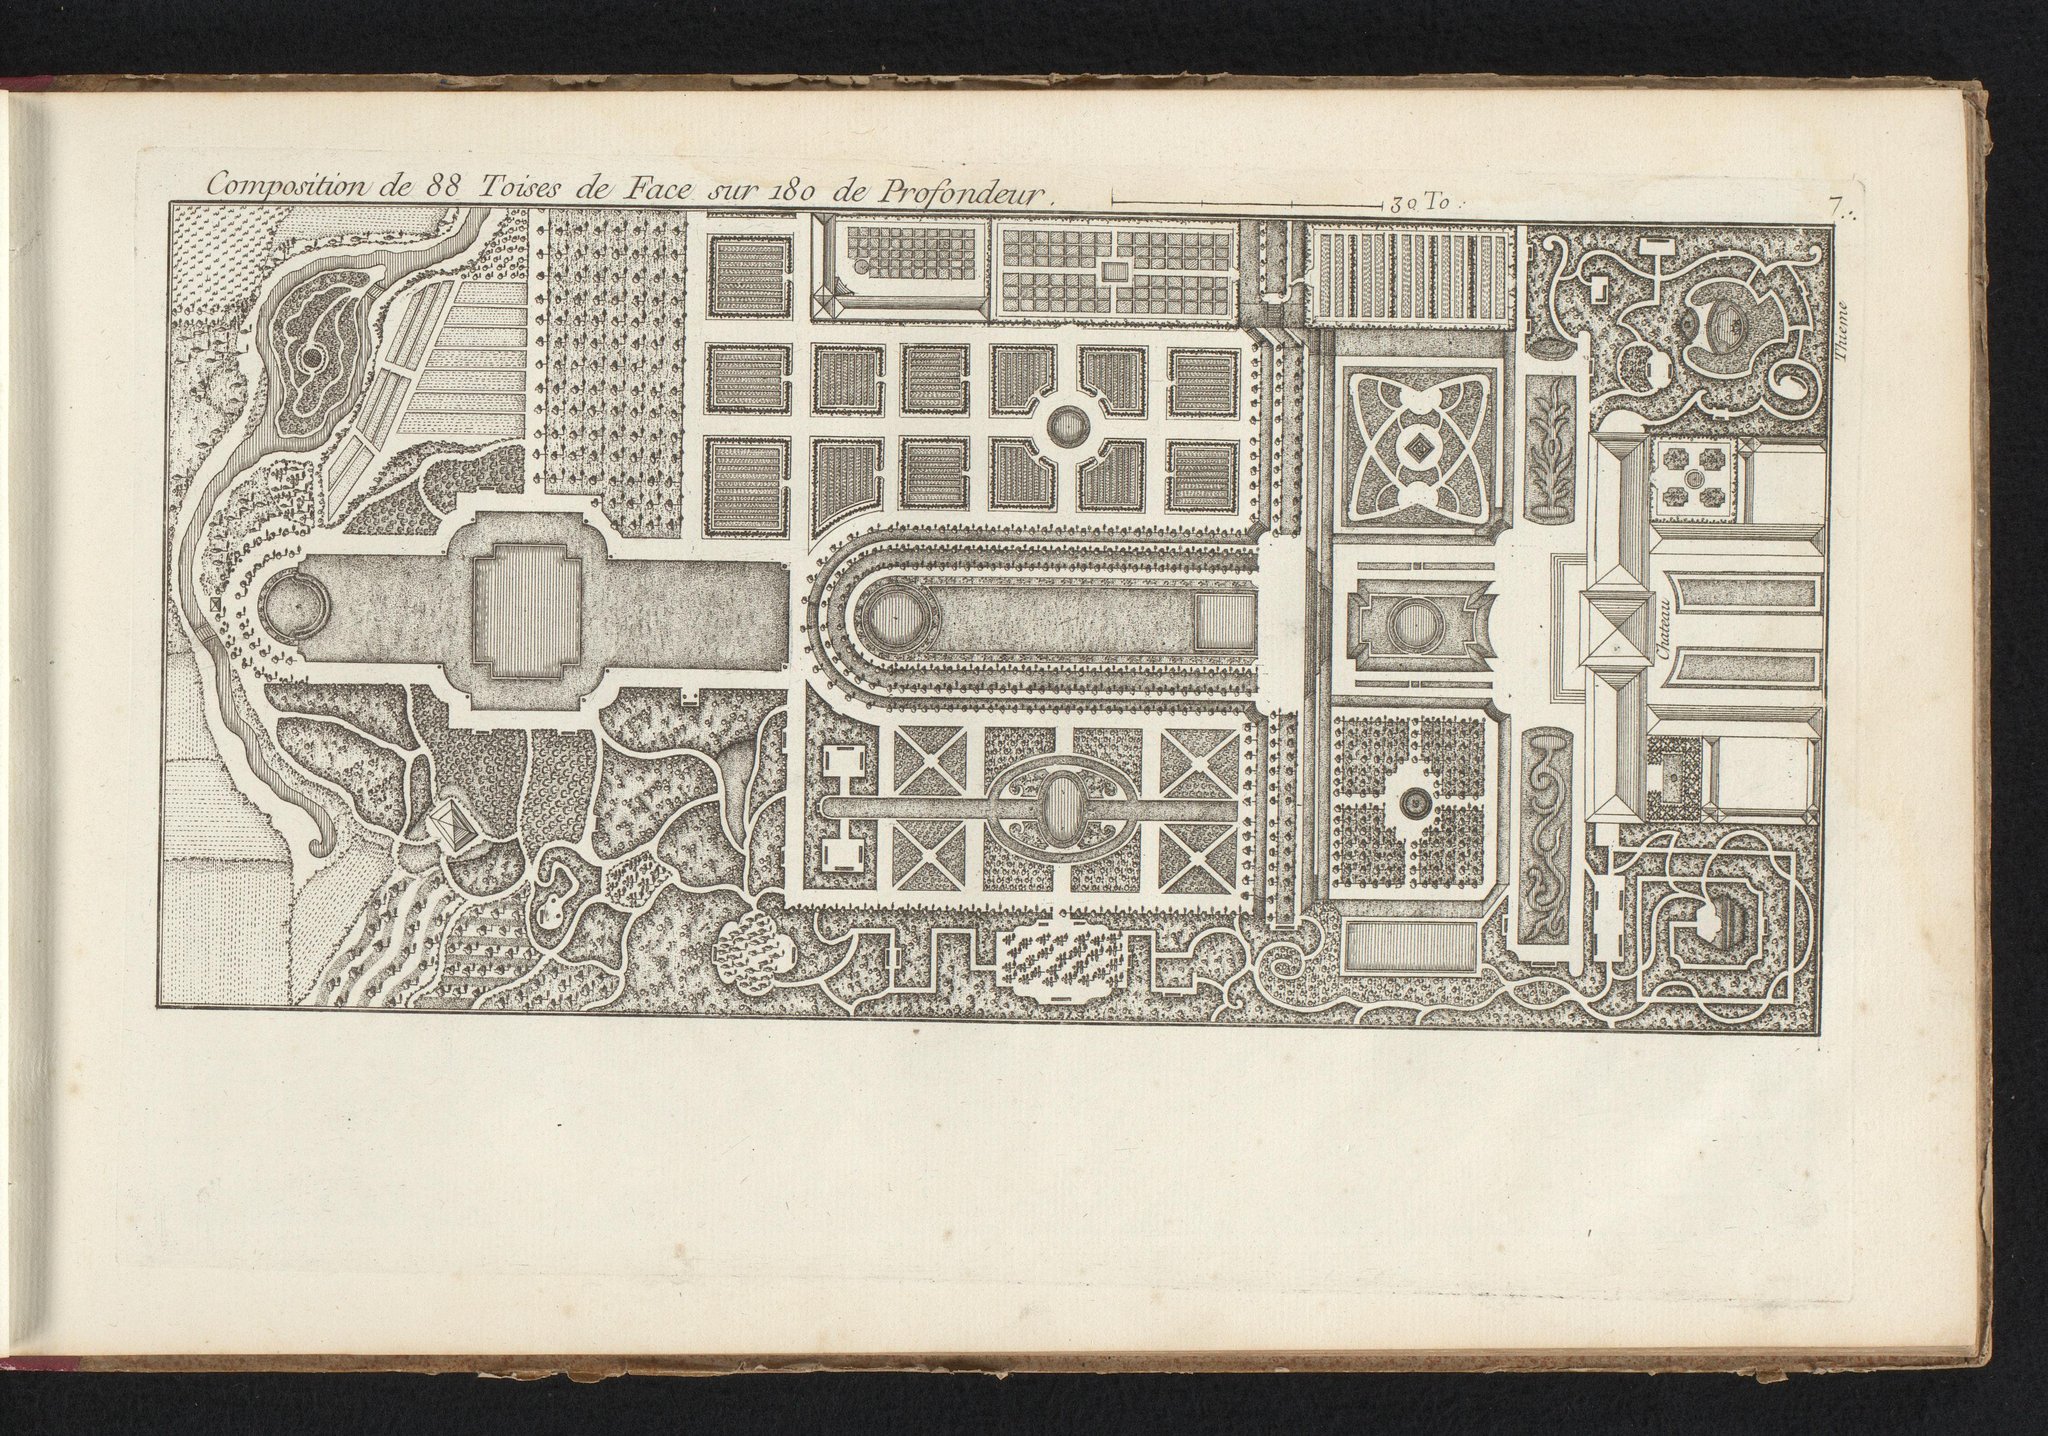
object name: album leaf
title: Ontwerp voor de tuin bij een kasteel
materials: paper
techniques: engraving, etching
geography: paris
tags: plan, map of garden, lay-out of garden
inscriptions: collector's mark: Lugt 2760, collector's mark: Lugt 2228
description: De serie 'Jardins anglo-chinois à la mode' verscheen in totaal in 21 zogeheten 'cahiers' (afleveringen). De huidige prent komt uit het derde 'cahier'. Het Rijksmuseum Amsterdam bezit drie banden met daarin in totaal zes 'cahiers' van deze reeks. In de documentatie wordt verwezen naar een in de bibliotheek van het Rijksmuseum Amsterdam aanwezige facsimile van het complete werk.